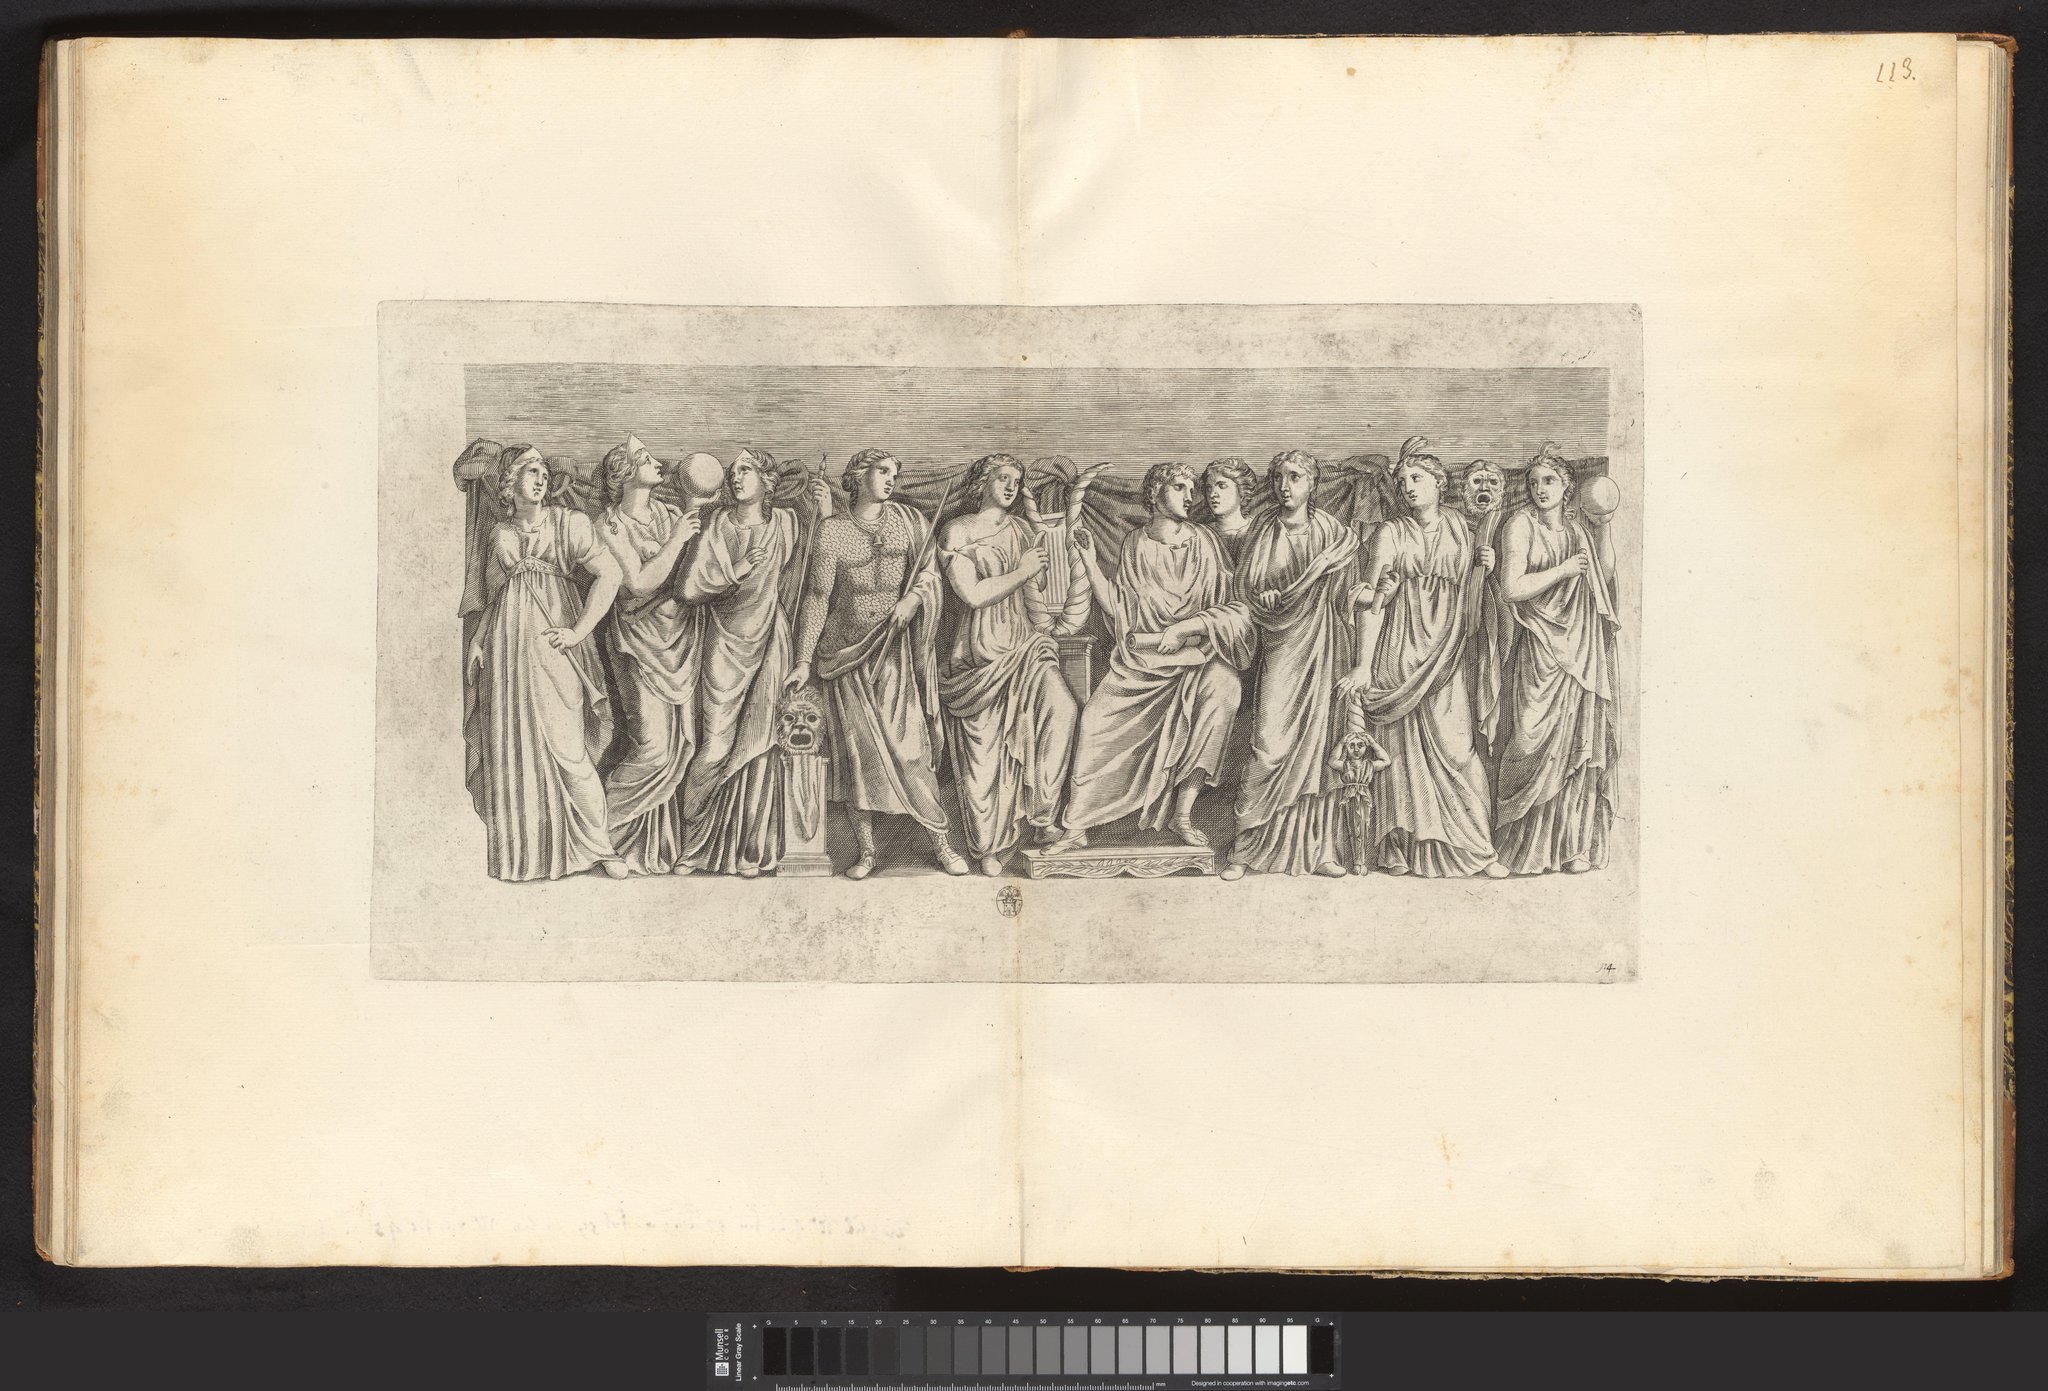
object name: album leaf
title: Galleria Giustiniana del Marchese Vincenzo Giustiniani II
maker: reinier van persijn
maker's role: draughtsman, painter, print maker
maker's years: 1614-1668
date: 1636-1647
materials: paper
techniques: engraving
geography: rome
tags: shaking hands, 'dextrarum junctio', piece of sculpture, reproduction of a piece of sculpture, gripping someone by the hand or the wrist; clasped hands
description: Bas-reliëf met twee soldaten die in een tempel elkaar de hand schudden als symbool van eendracht. De rechterman draagt een kroon. Midden onder het wapenschild van Vincenzo Giustiniani. Prent maakt deel uit van een album met een serie prenten naar de sculpturen in de verzameling in de Galleria Giustiniani te Rome.